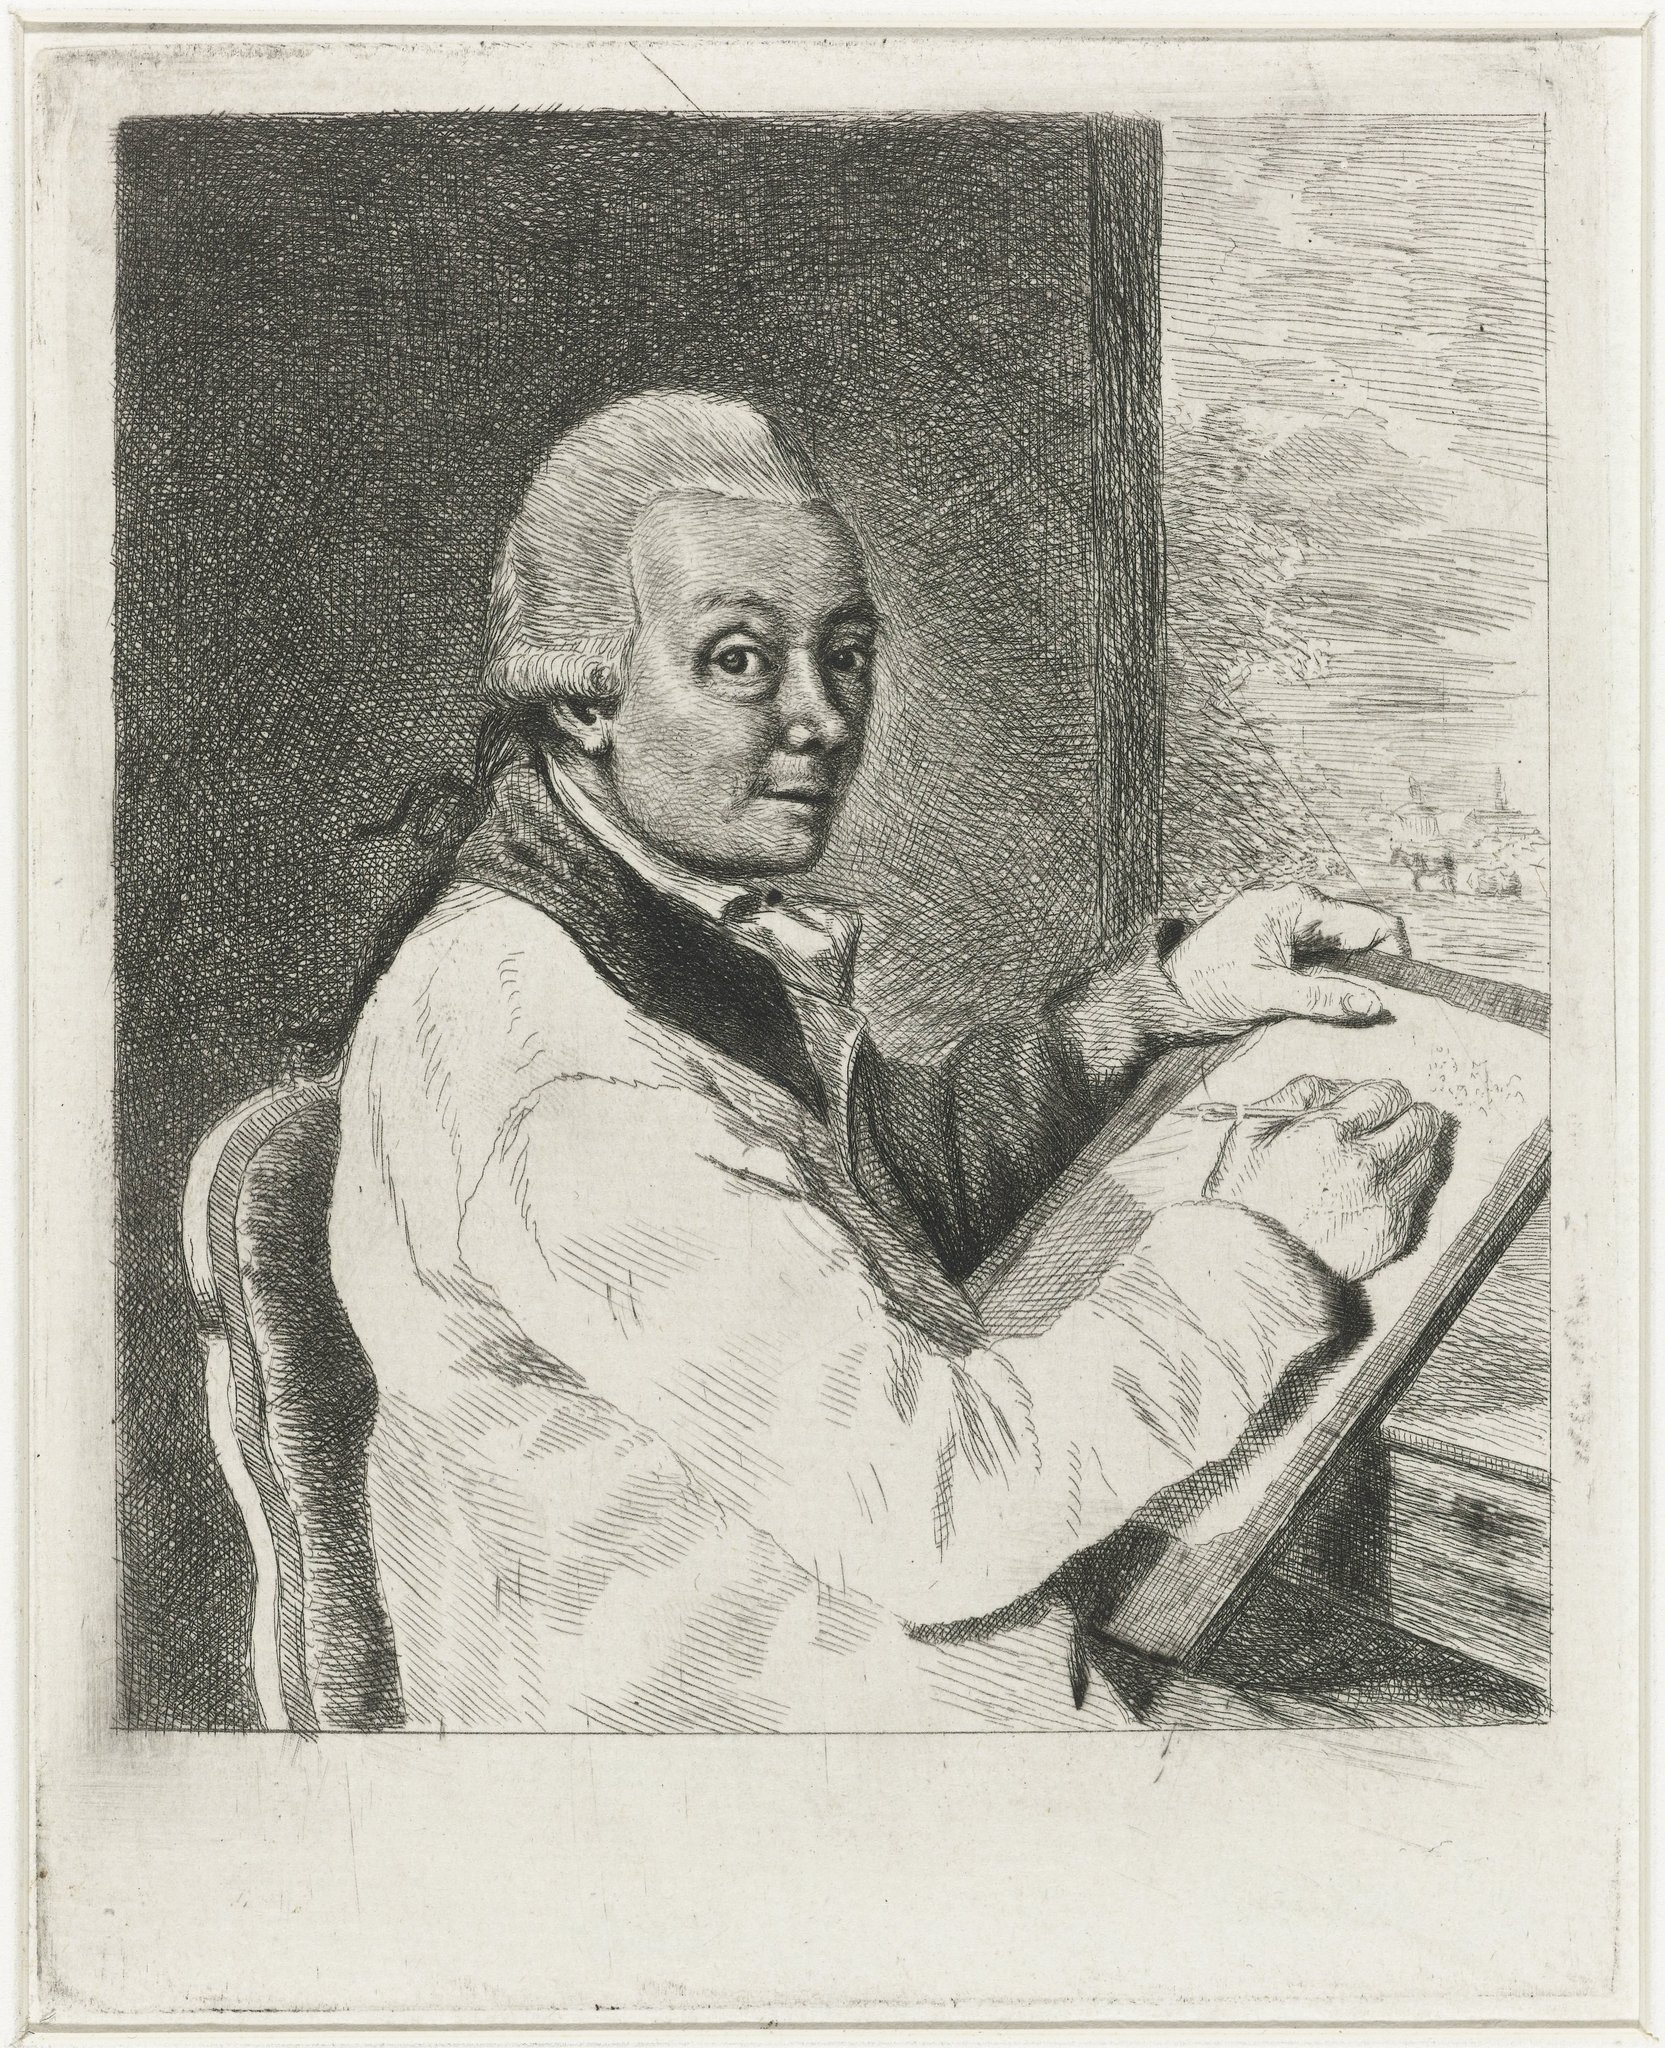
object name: print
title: Portret van de kunstenaar Johannes Janson, tekenend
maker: louis bernard coclers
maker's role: draughtsman, print maker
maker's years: 1741-1817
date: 1769-1787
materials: paper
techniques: drypoint, etching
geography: leiden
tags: leiden, painter, print maker, draughtsman, johannes janson, portrait, self-portrait of artist (+ making preliminary designs, sketching)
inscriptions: collector's mark: Lugt 2228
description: Johannes Janson zittend bij het raam met en tekenplank in de hand. Janson draagt een pruik en een jasje met donkere kraag.